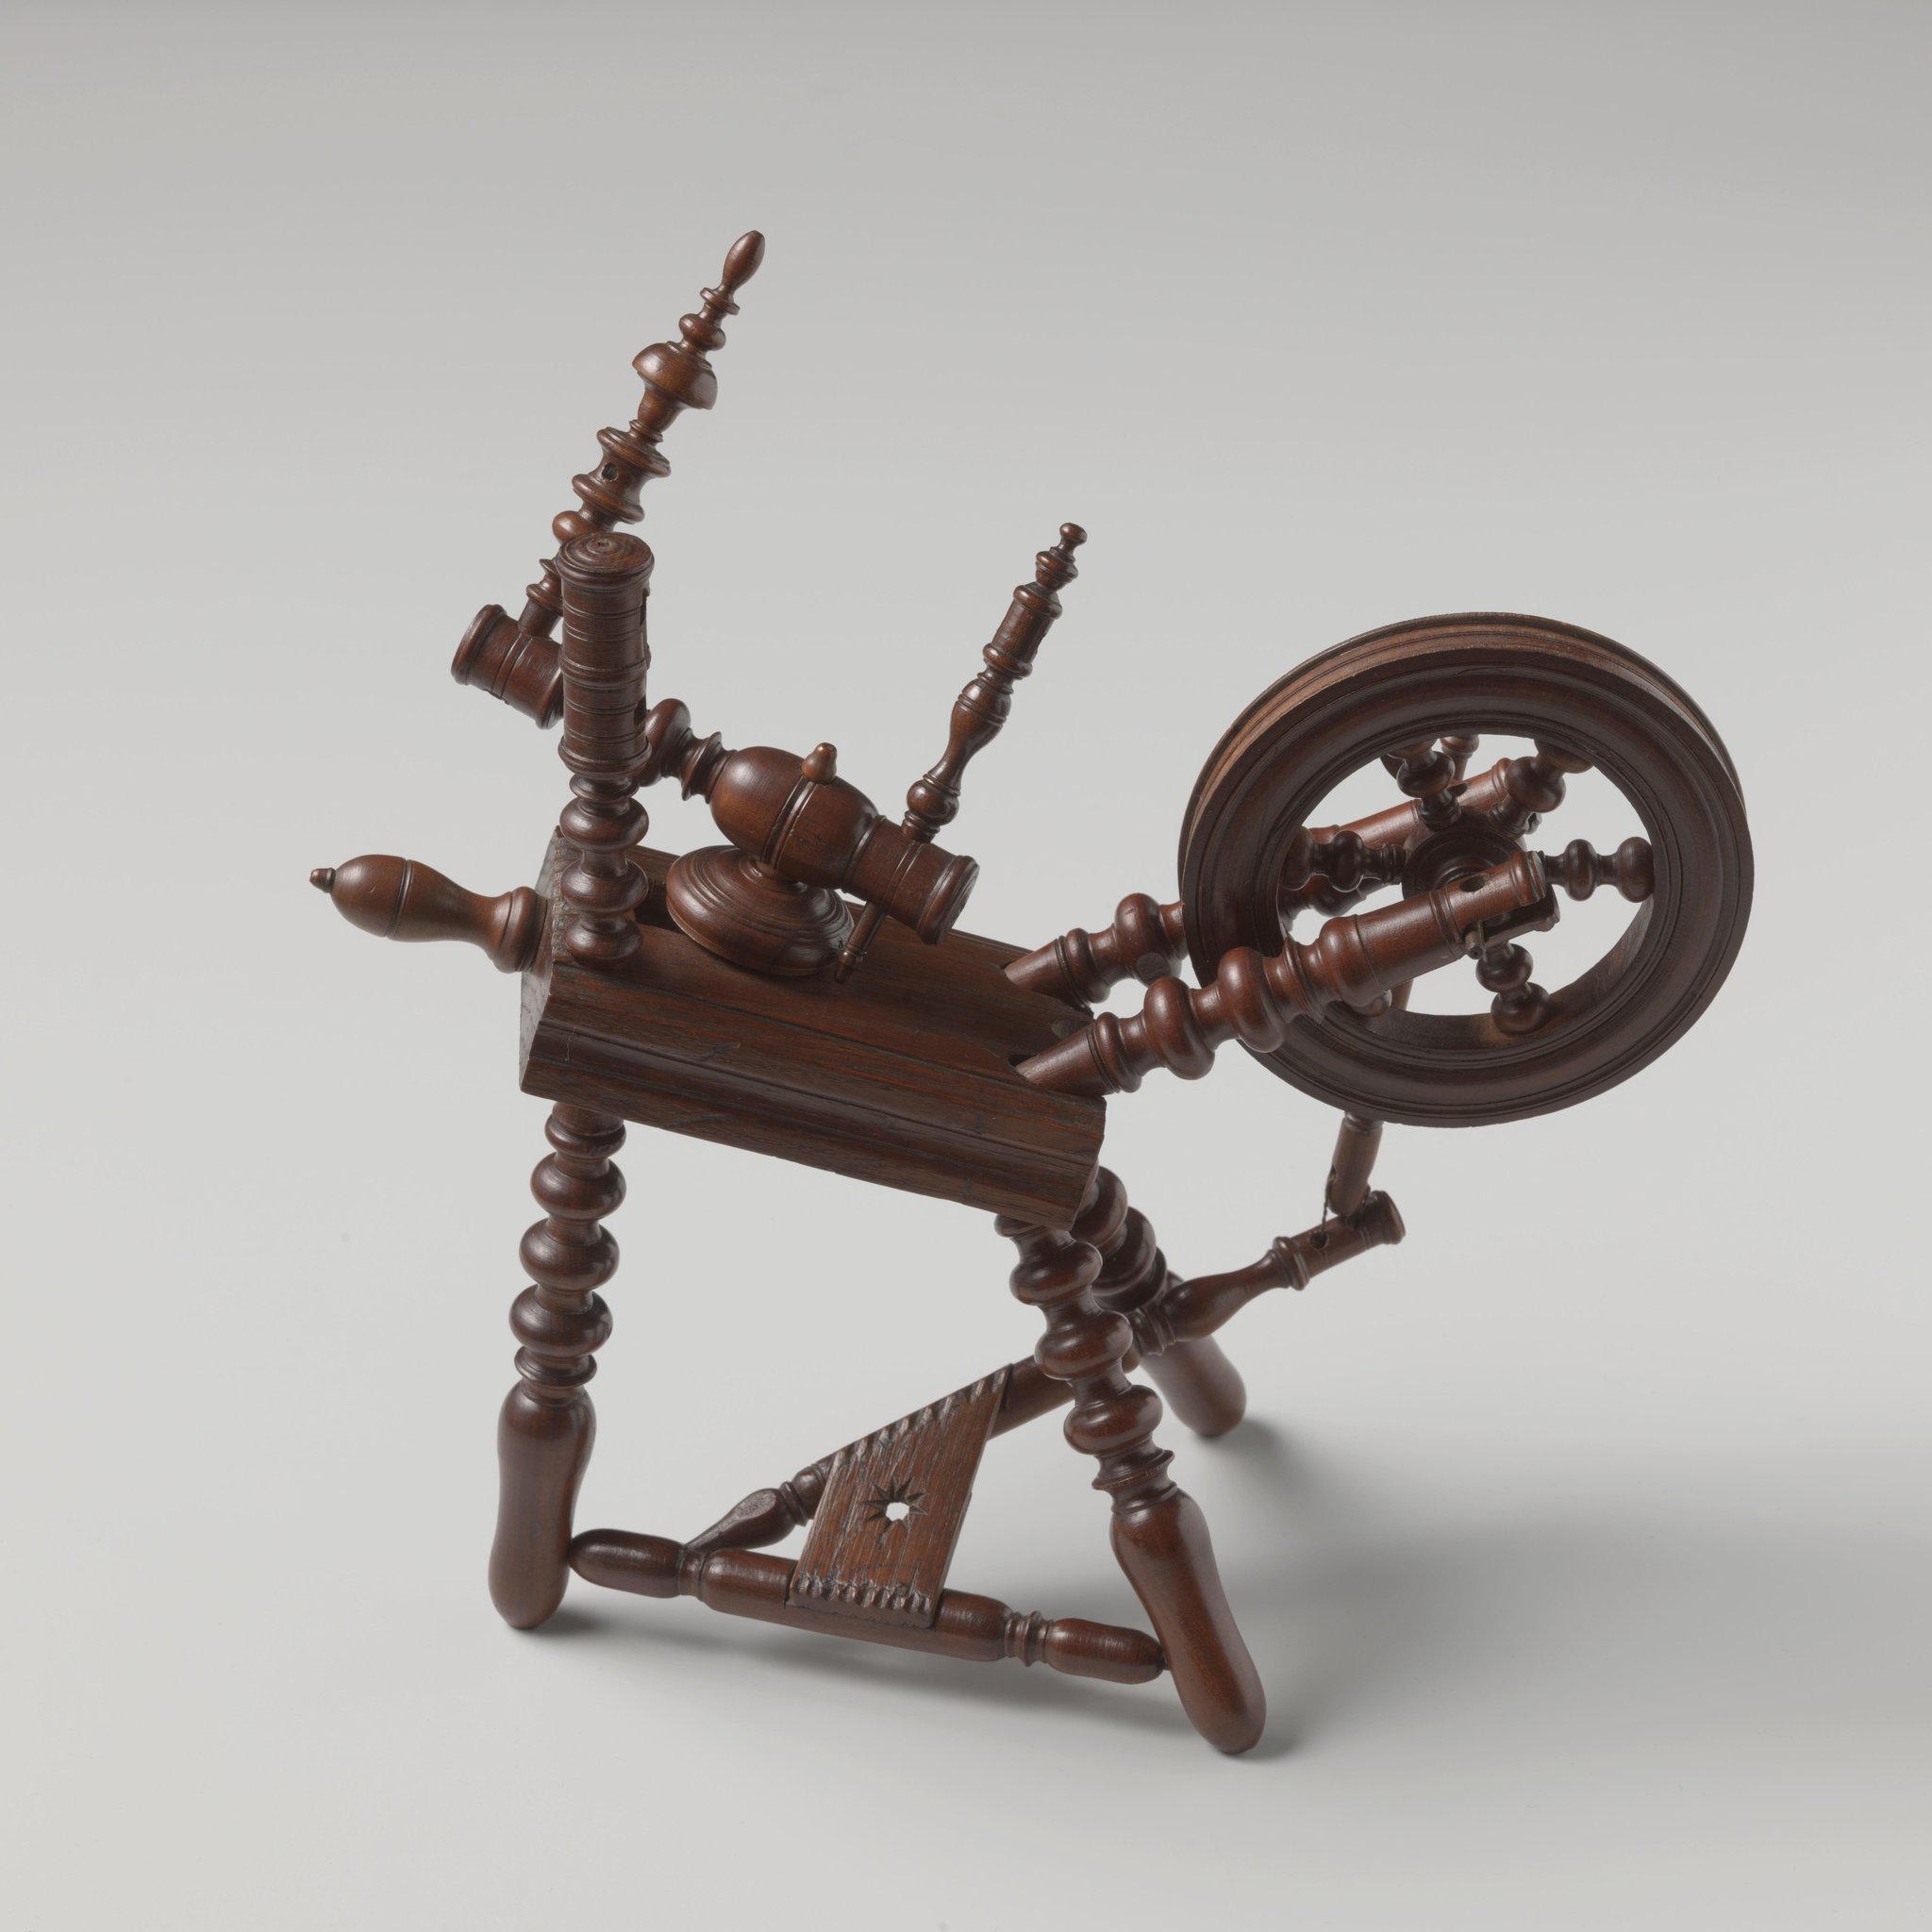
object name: spinning wheel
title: Spinnewiel, miniatuur, met gedraaide spijlen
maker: Anonymous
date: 1600-1900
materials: wood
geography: northern netherlands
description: Spinnewiel in miniatuur van palissander- en zwart notenhout. Alle spijlen hebben gedraaide geledingen.